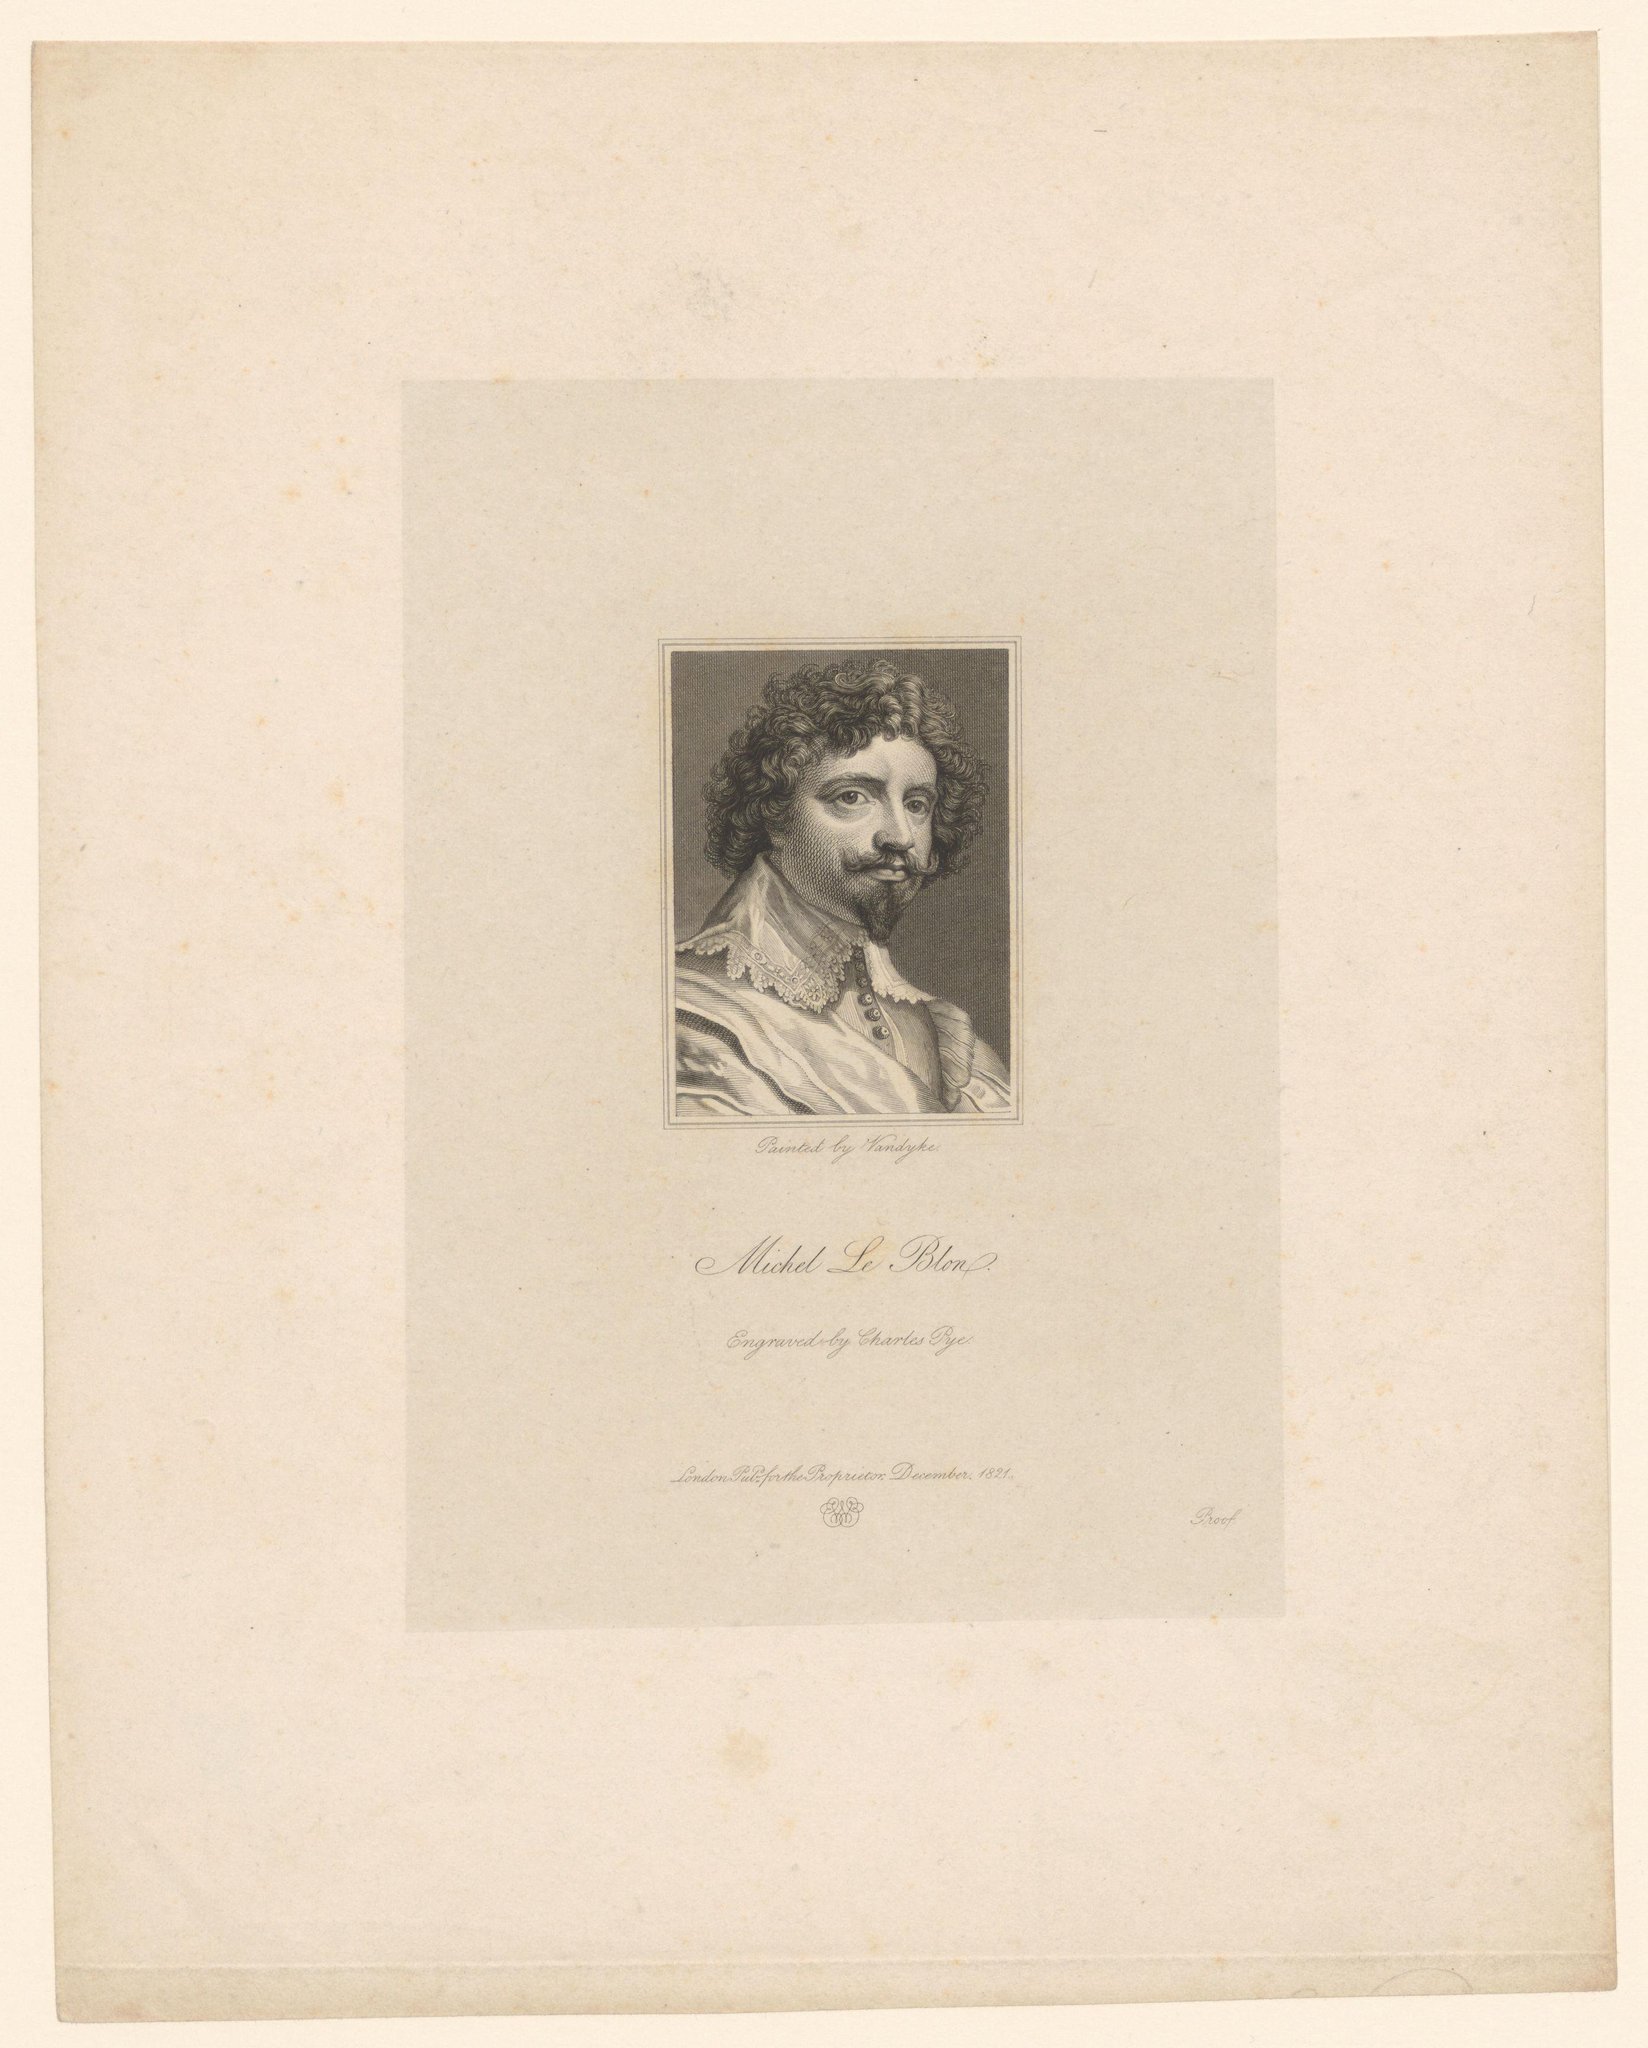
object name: print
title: Portret van Michel Le Blon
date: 1821-1822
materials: paper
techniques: engraving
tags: amsterdam, michiel le blon, historical persons, portrait, self-portrait of graphic artist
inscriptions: collector's mark: Lugt 2228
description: Prent gebruikt in: Walmsley, Edward. Physiognomical portraits. Londen: John Major, 1822.